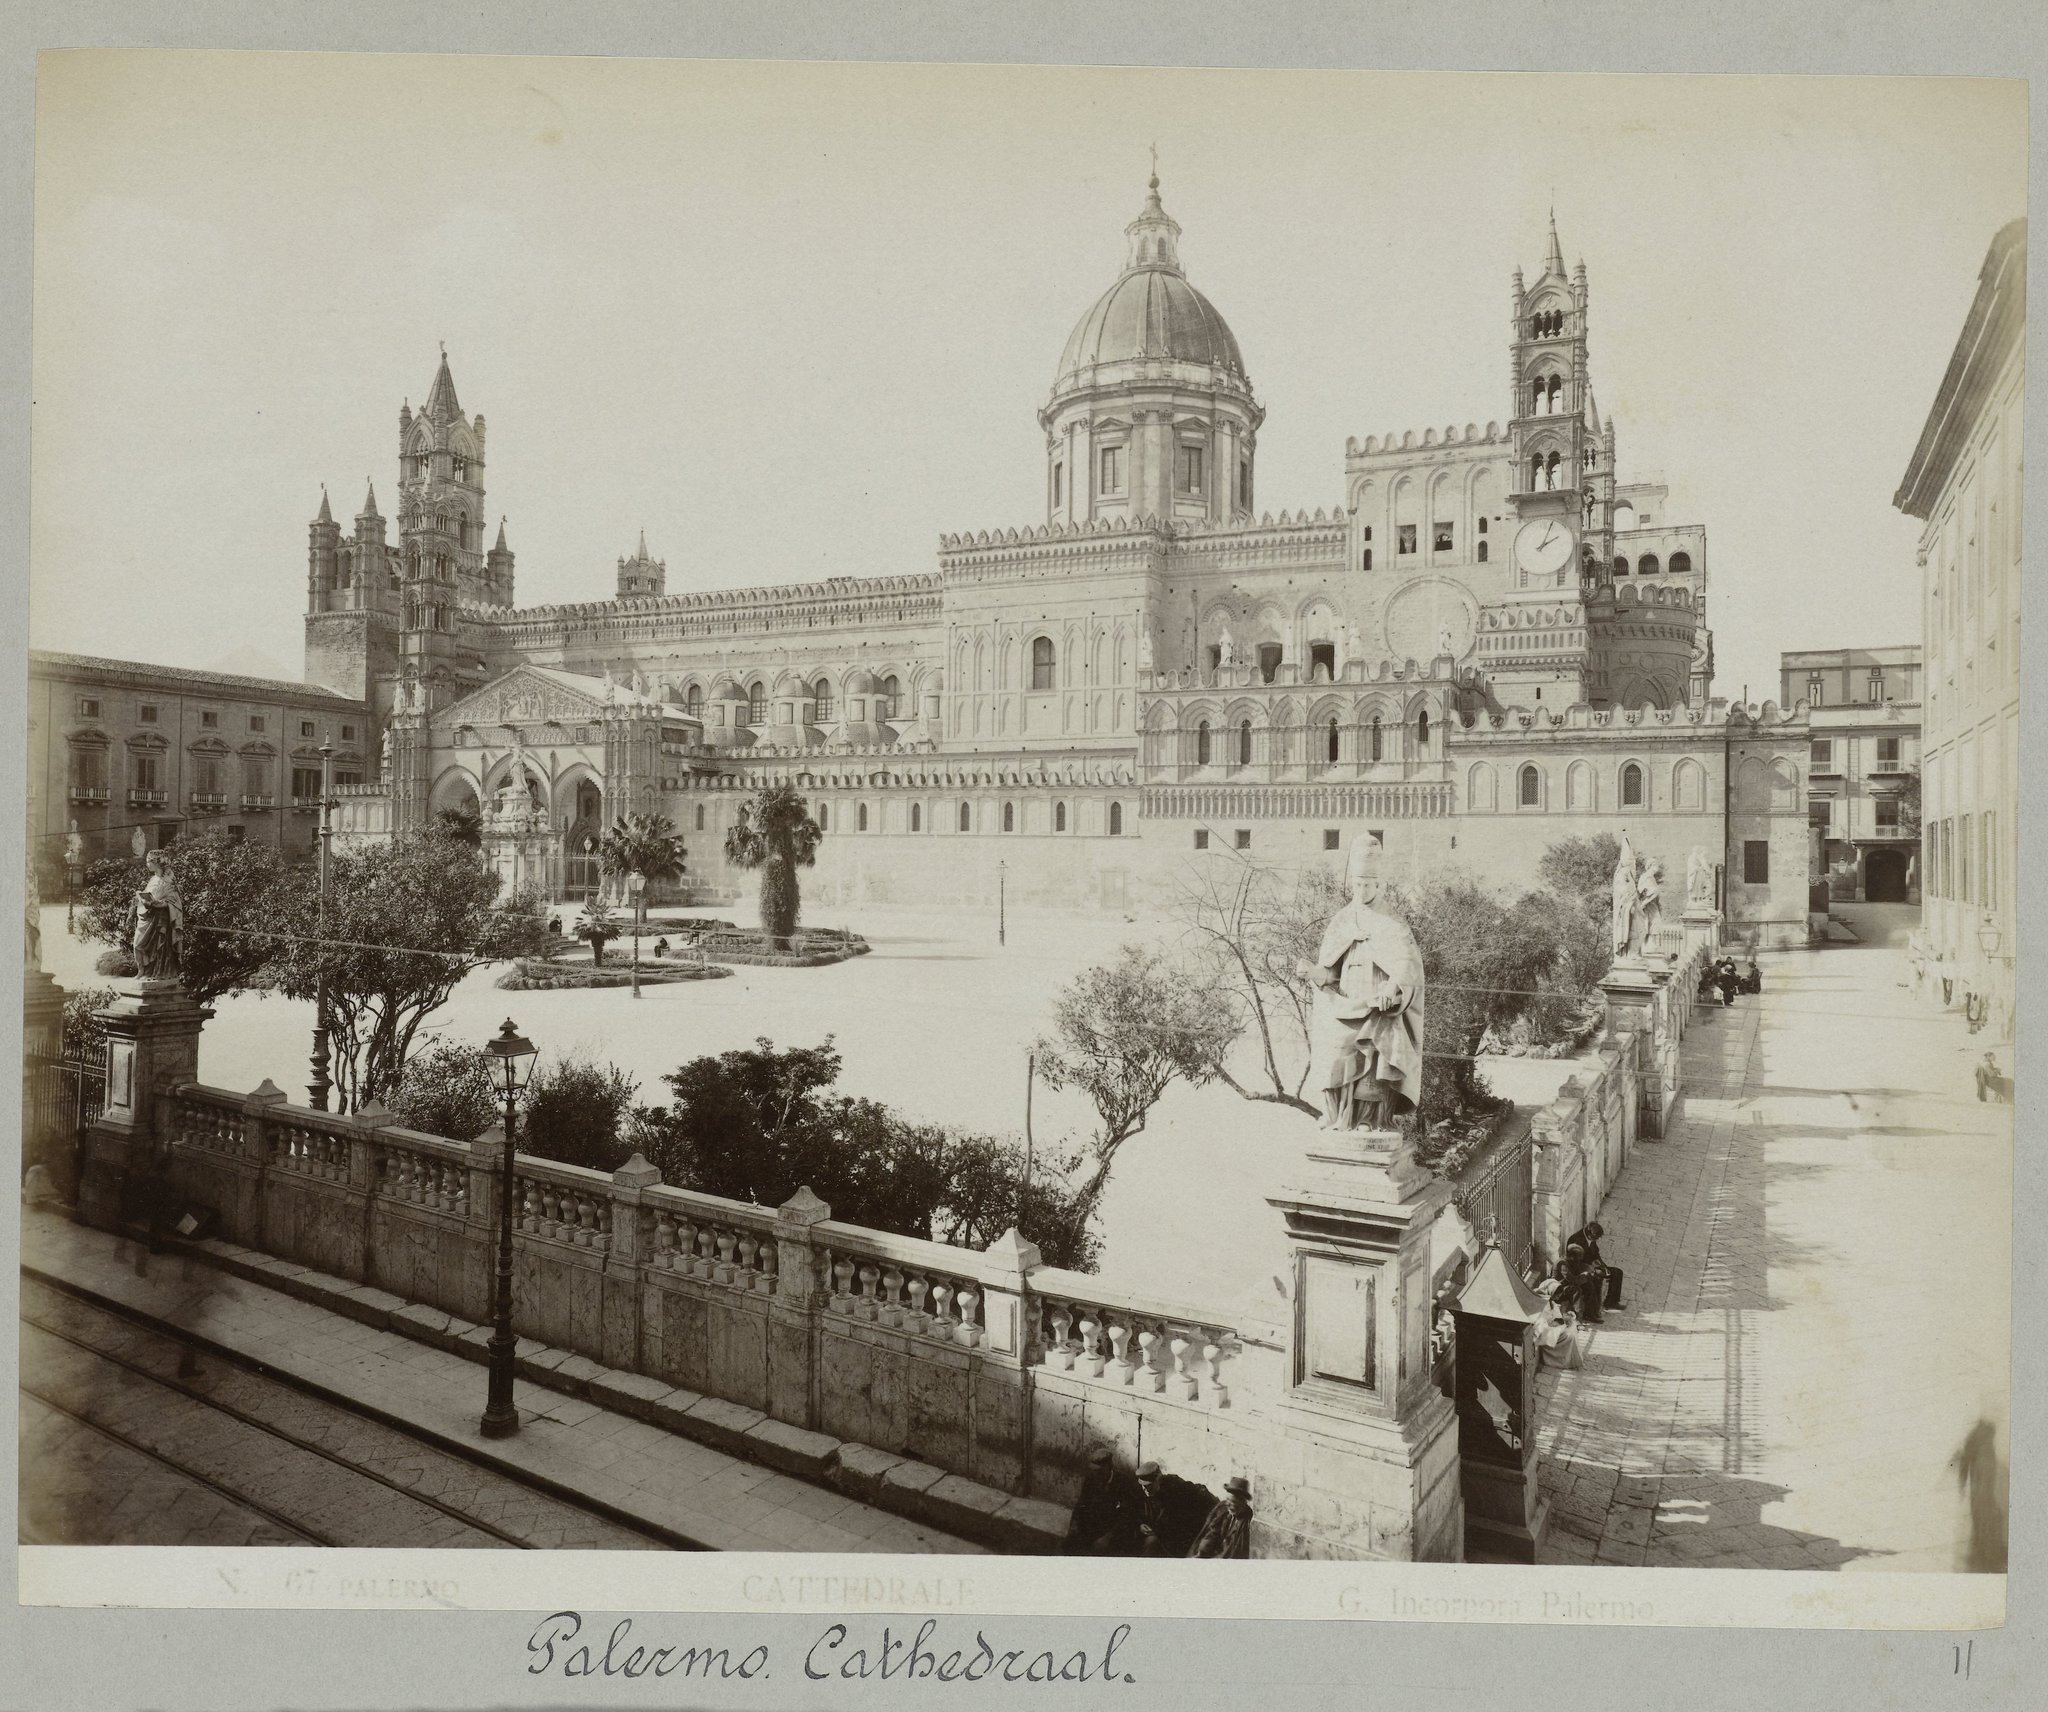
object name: photograph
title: N. 67 Palermo Cathedrale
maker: giuseppe incorpora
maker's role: fotograaf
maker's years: 1834-1914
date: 1893-1903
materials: cardboard, photographic support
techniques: albumen print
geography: palermo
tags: palermo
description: De Kathedraal van Palermo met het ommuurde plein.